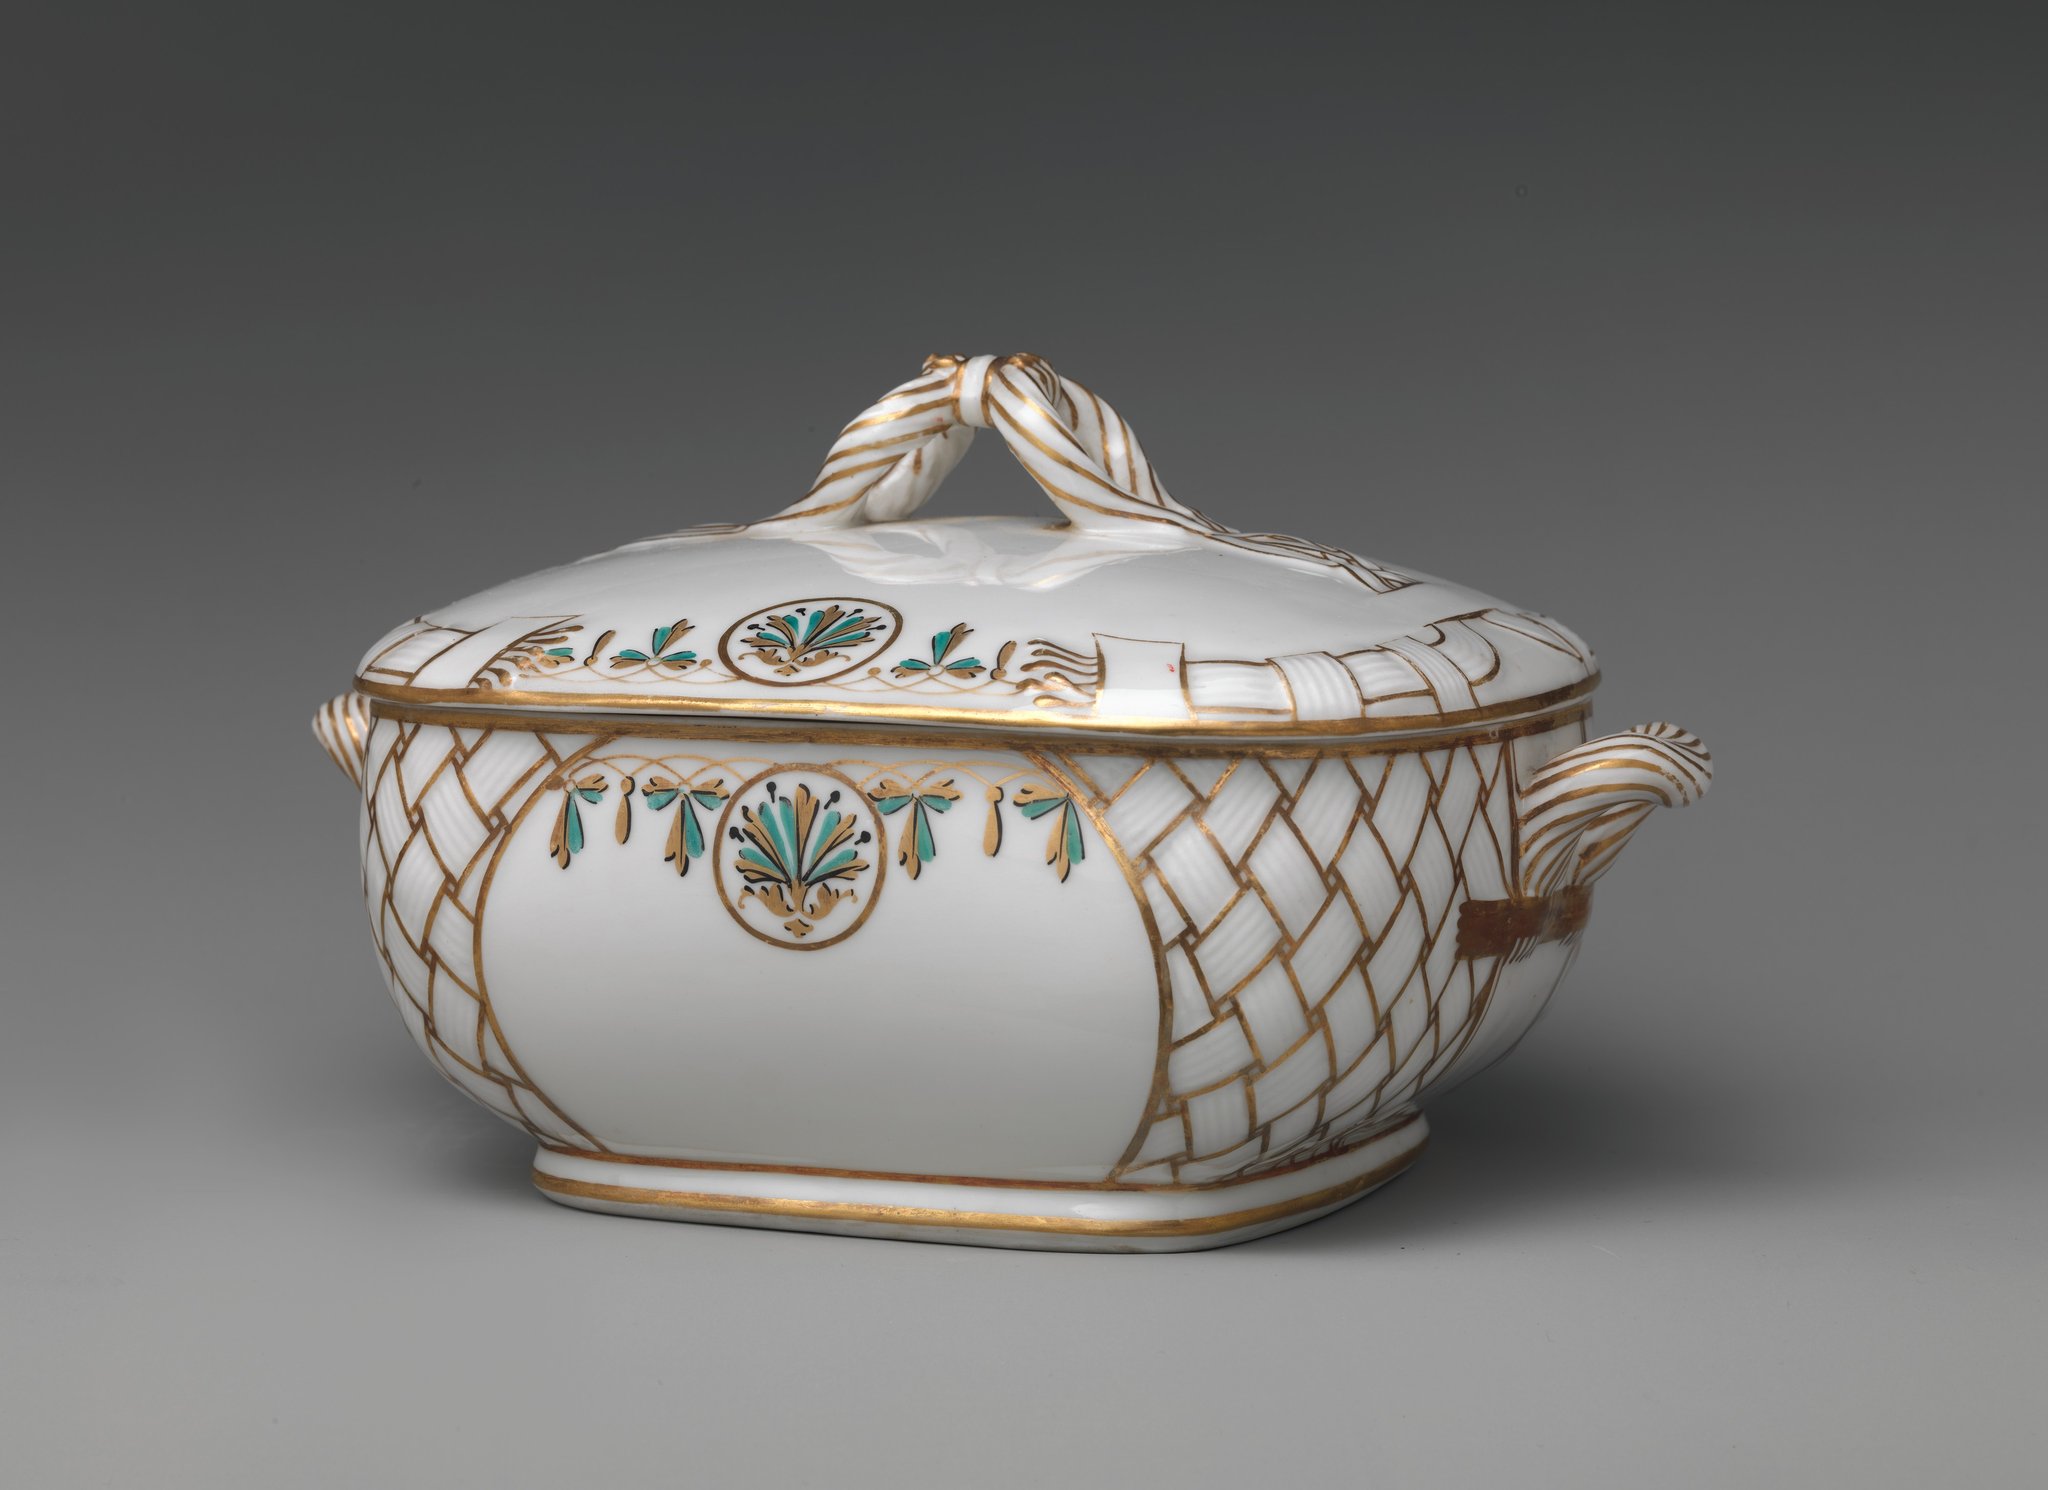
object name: vegetable dish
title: Covered Vegetable Dish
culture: american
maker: union porcelain works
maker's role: maker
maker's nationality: american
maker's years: 1863-1922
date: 1885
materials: porcelain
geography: united states